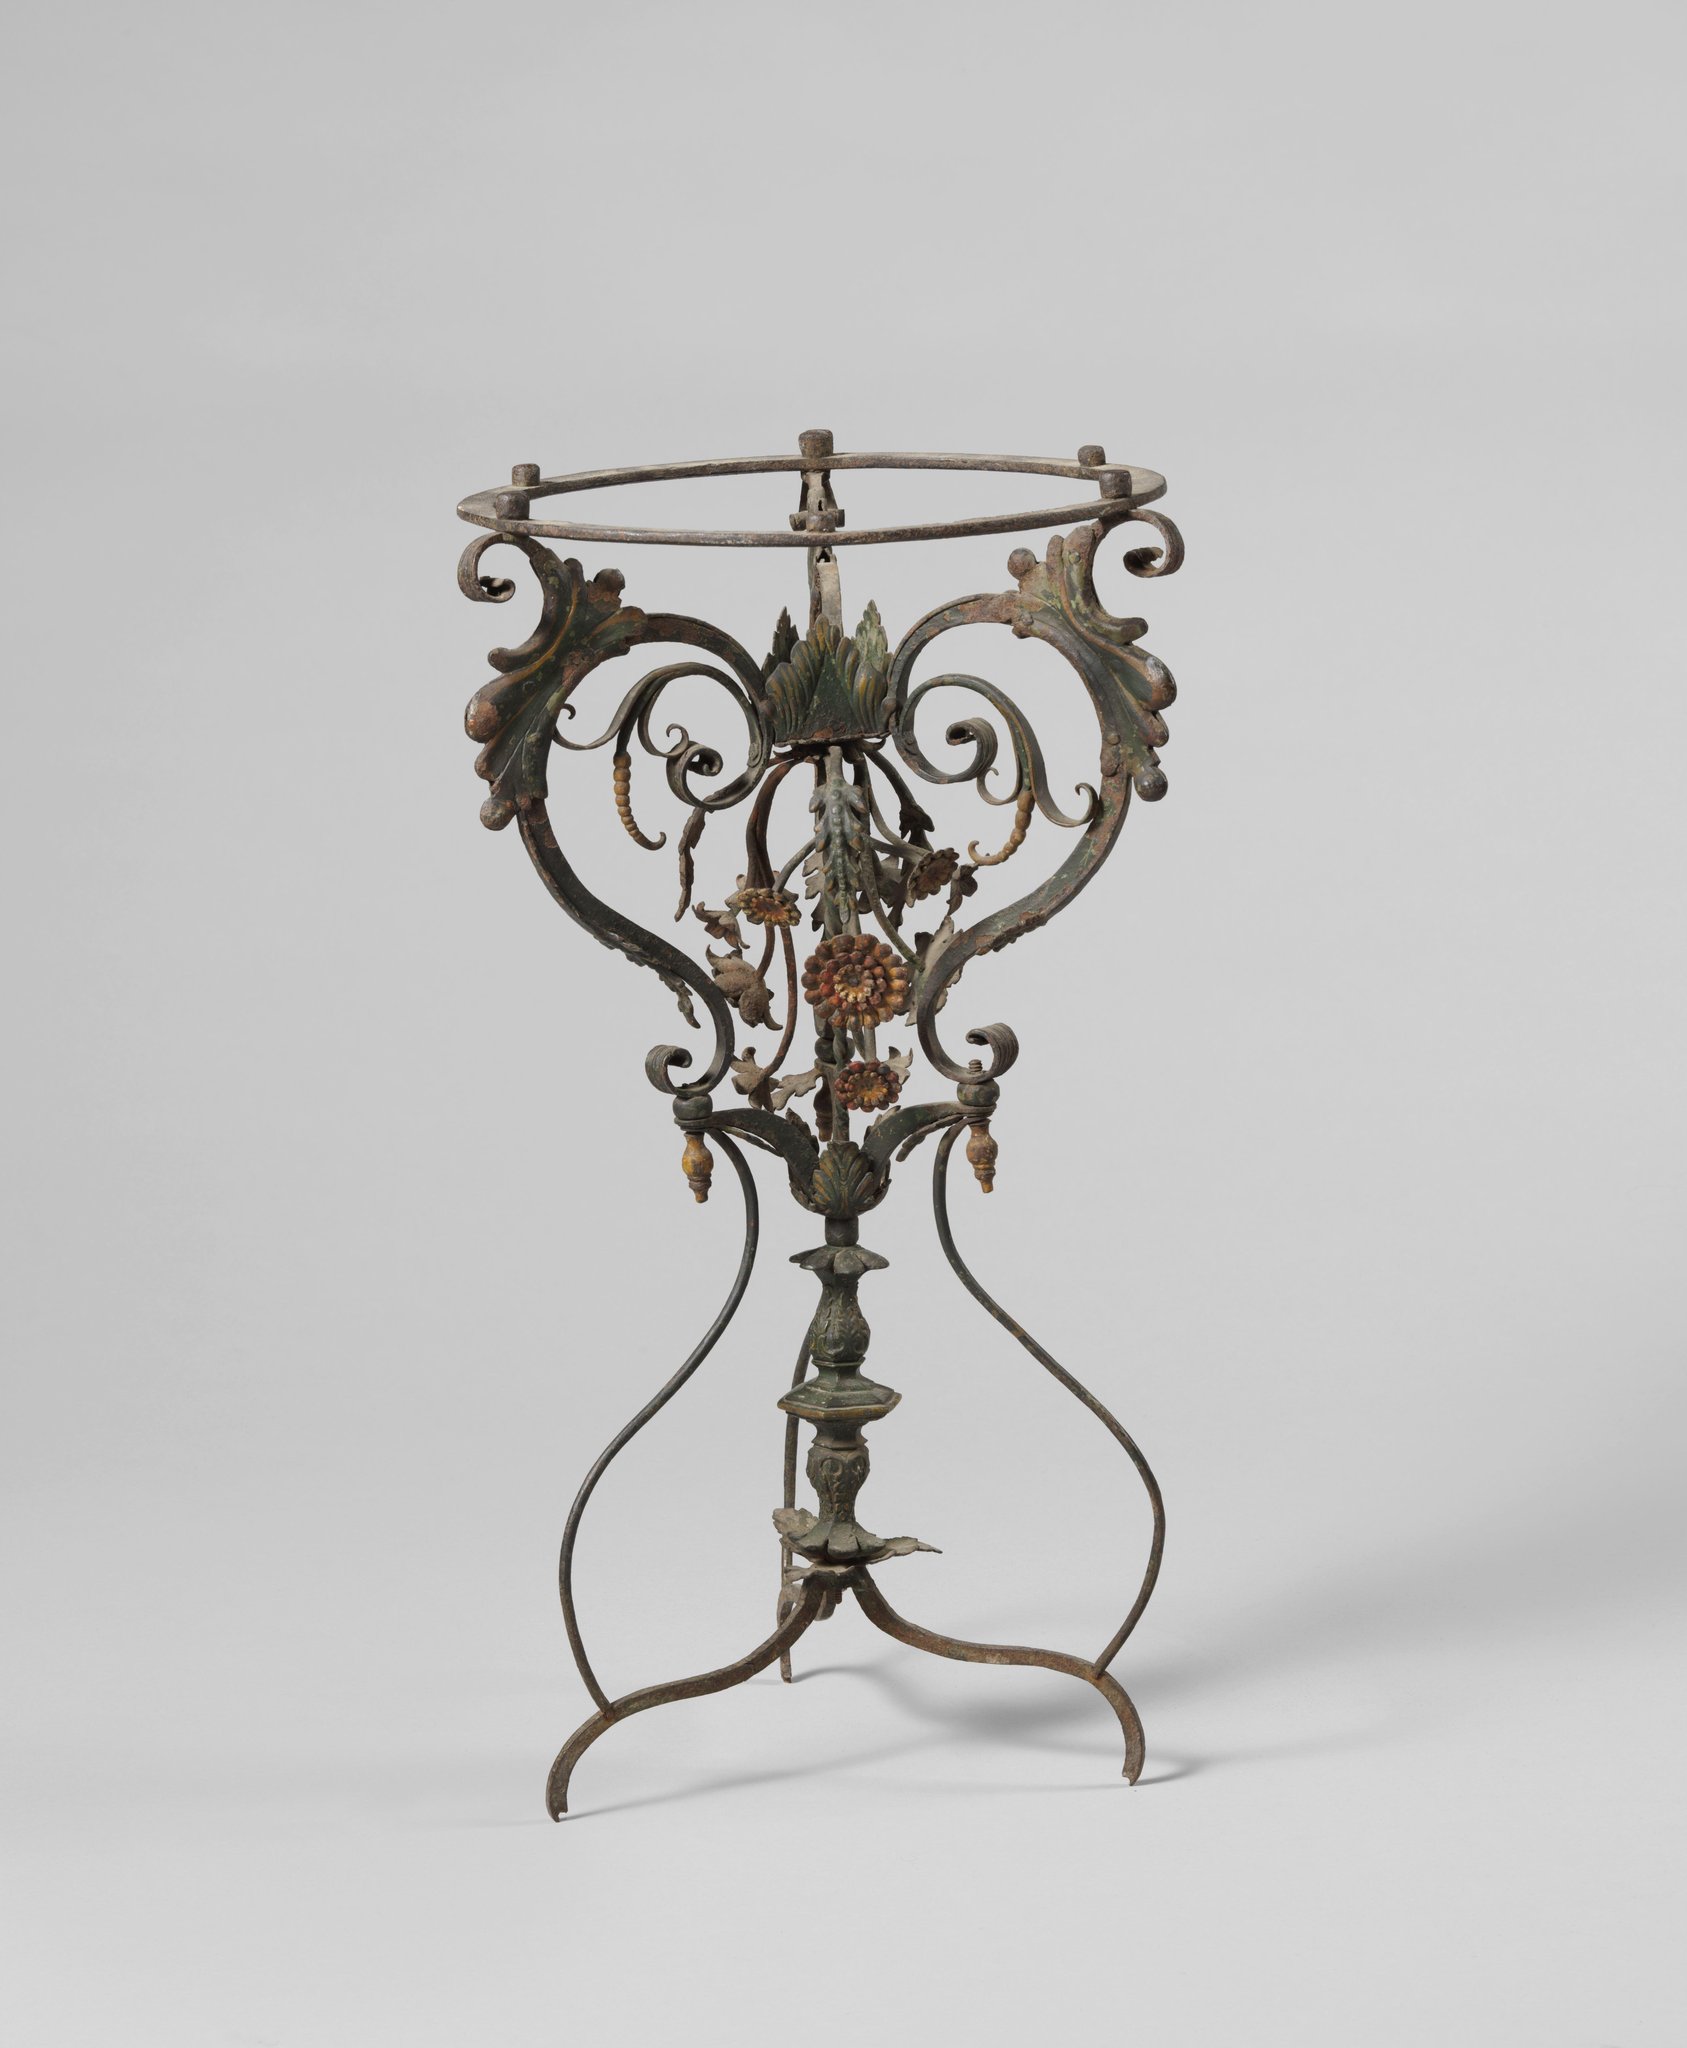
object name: stand support object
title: Standaard van ijzer, drievoet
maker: Anonymous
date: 1400-1950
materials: iron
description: Een ijzeren standaard, drievoet, waarschijnlijk gediend hebbende als voet van een doopbekken.